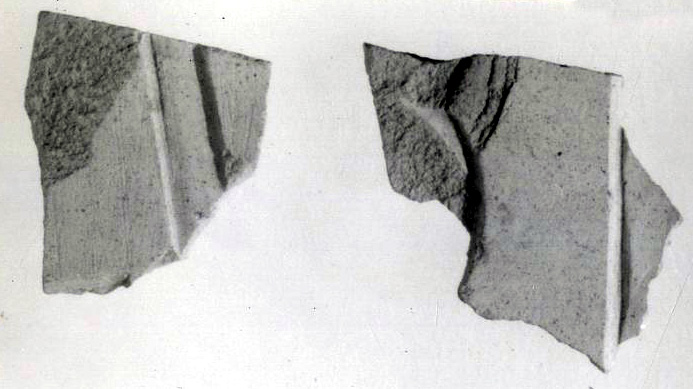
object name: relief fragment, tomb of meketre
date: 1981-1975 BCE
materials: limestone, paint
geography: egypt